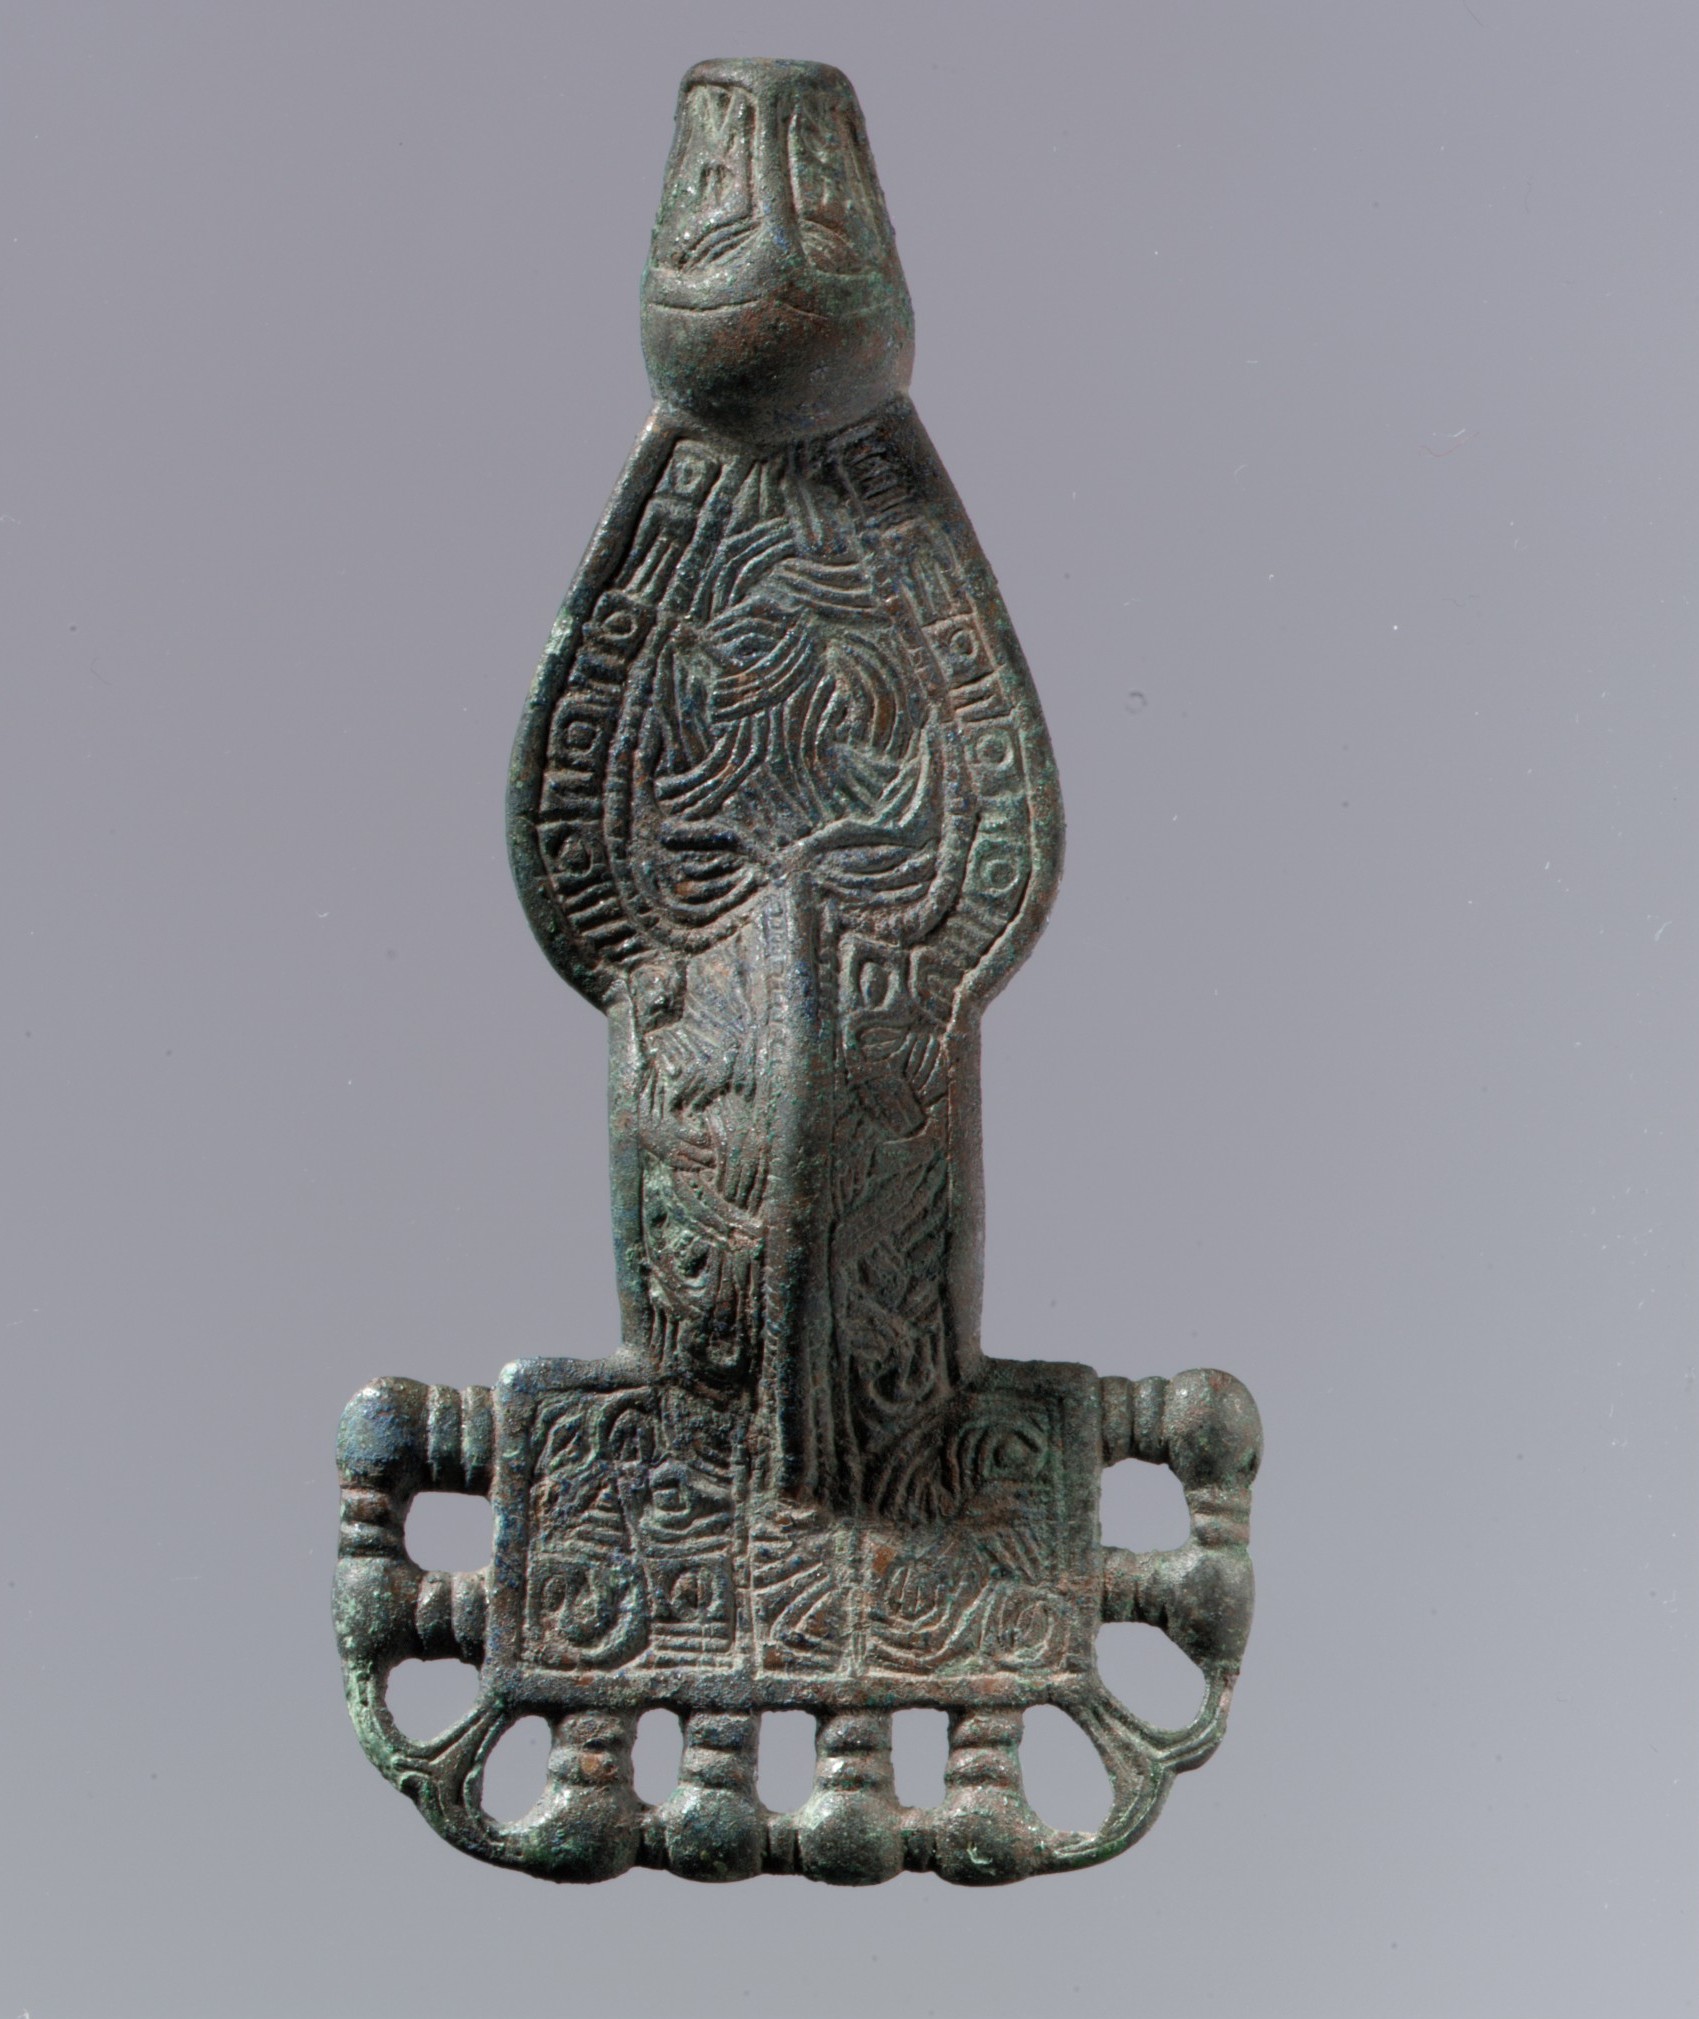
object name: brooch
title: Square-Headed Bow Brooch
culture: frankish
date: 501-600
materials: copper alloy